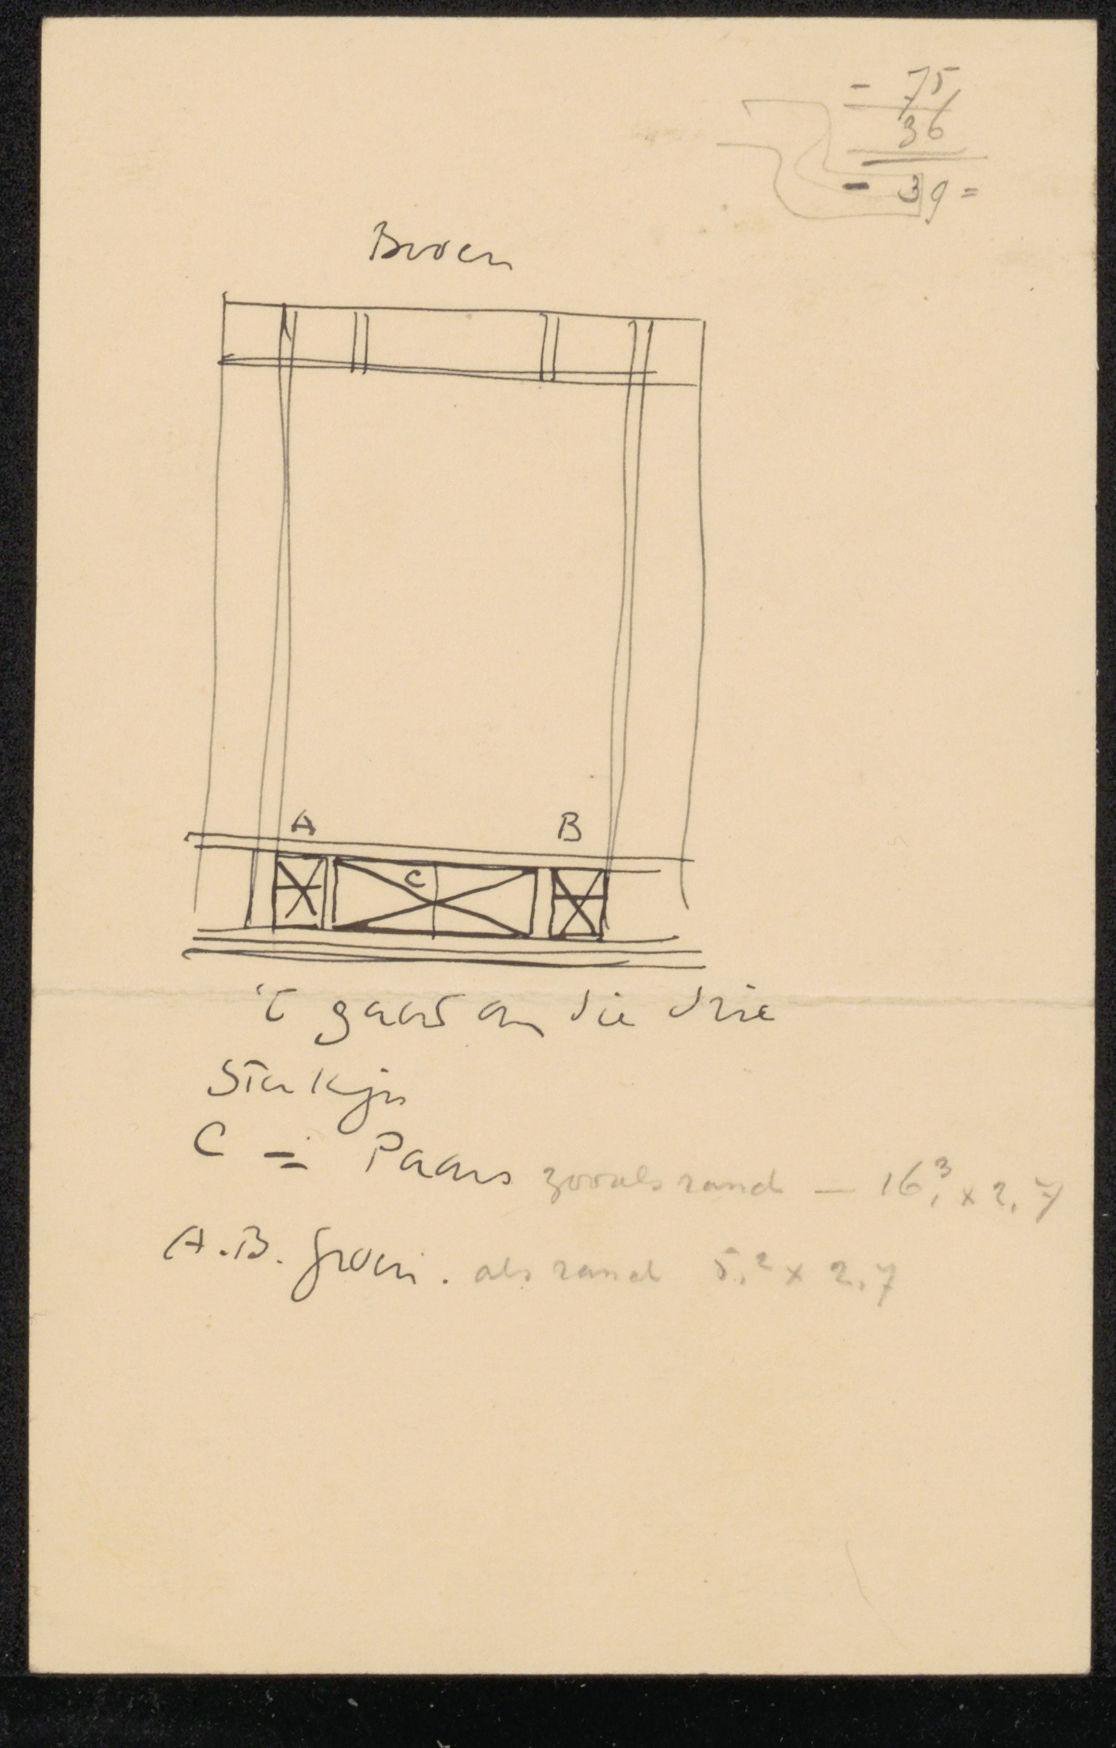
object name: letter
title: Briefkaart aan anoniem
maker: richard nicolaüs roland holst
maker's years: 1868-1938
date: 1892-1938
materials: cardboard, ink, pencil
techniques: pen, writing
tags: haarlem, willem bogtman, applied arts, arts and crafts; industrial design, plan ~ architecture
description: Briefkaart gericht aan vermoedelijk Willem Bogtman.